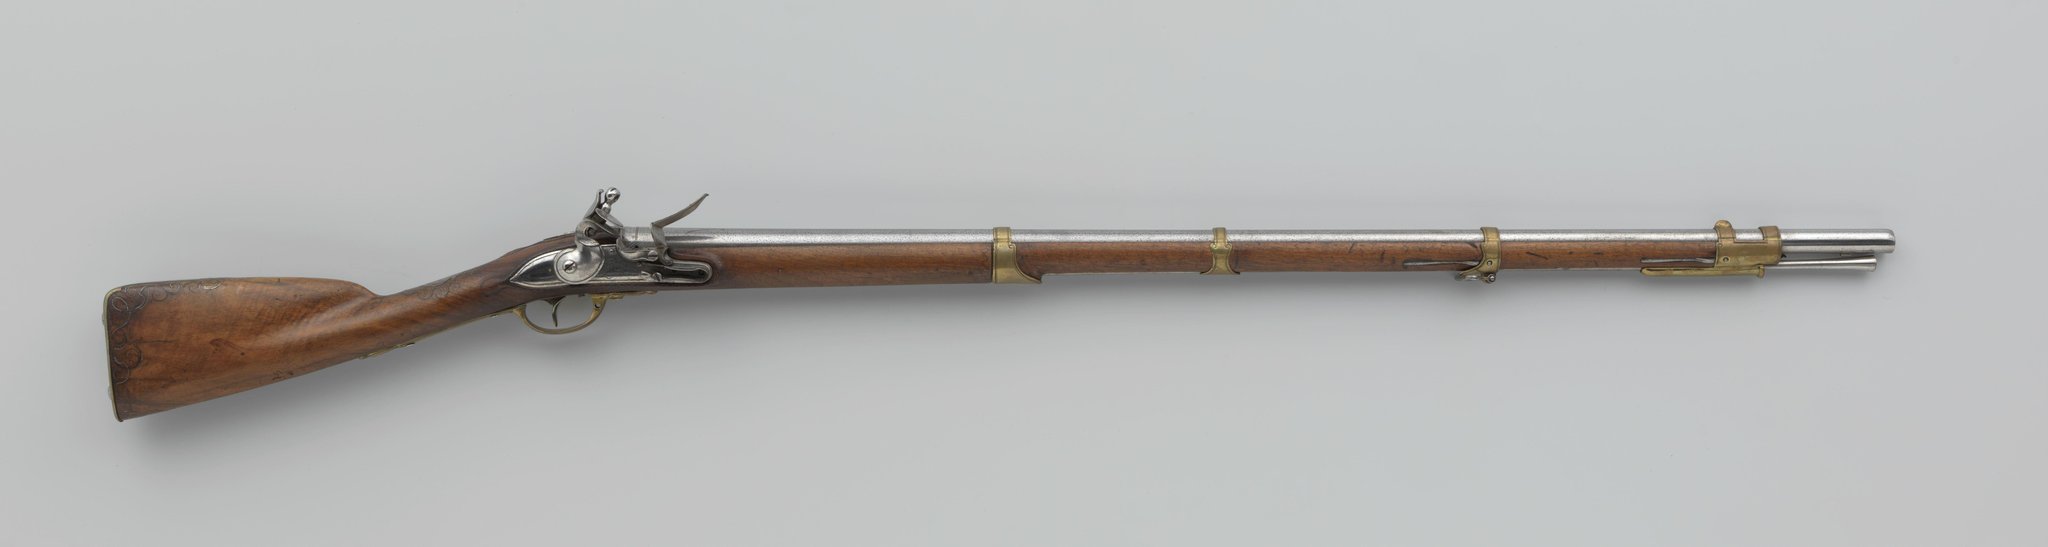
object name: flintlock pistol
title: Vuursteengeweer met batterijslot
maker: johan george ertel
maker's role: geweermaker, pistoolmaker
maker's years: 1728-1795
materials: copper, iron, silver, wood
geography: amsterdam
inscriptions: mark: ‘J.G. Erttel Amsterdam’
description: Vuursteengeweer met batterijslot, gladde ronde loop en bij het staartstuk een profielband. De loop bij kamer gemerkt met keur van Amsterdam en het slot bevestigd met twee bouten. Op de slotplaat opschrift: J.G. Erttel Amsterdam. Notenhouten Franse kolf en ingelegd zilverdraad bij slot en op de kolf. Op kolfhals zilveren plaat met kroon van zilverdraad erboven. Vier messing banden om loop en lade, eerste met vizierkorrel boven en koker voor laadstok onder, tweede met scharnierend ijzeren oog. Trekkerbeugel met dubbele lijnen en bladmotieven. Tegenslotplaat dakvormig met twee ogen voor slotbouten en een voor schroef waarmee trekker bevestigd is. Kolfkap met vier schroeven.